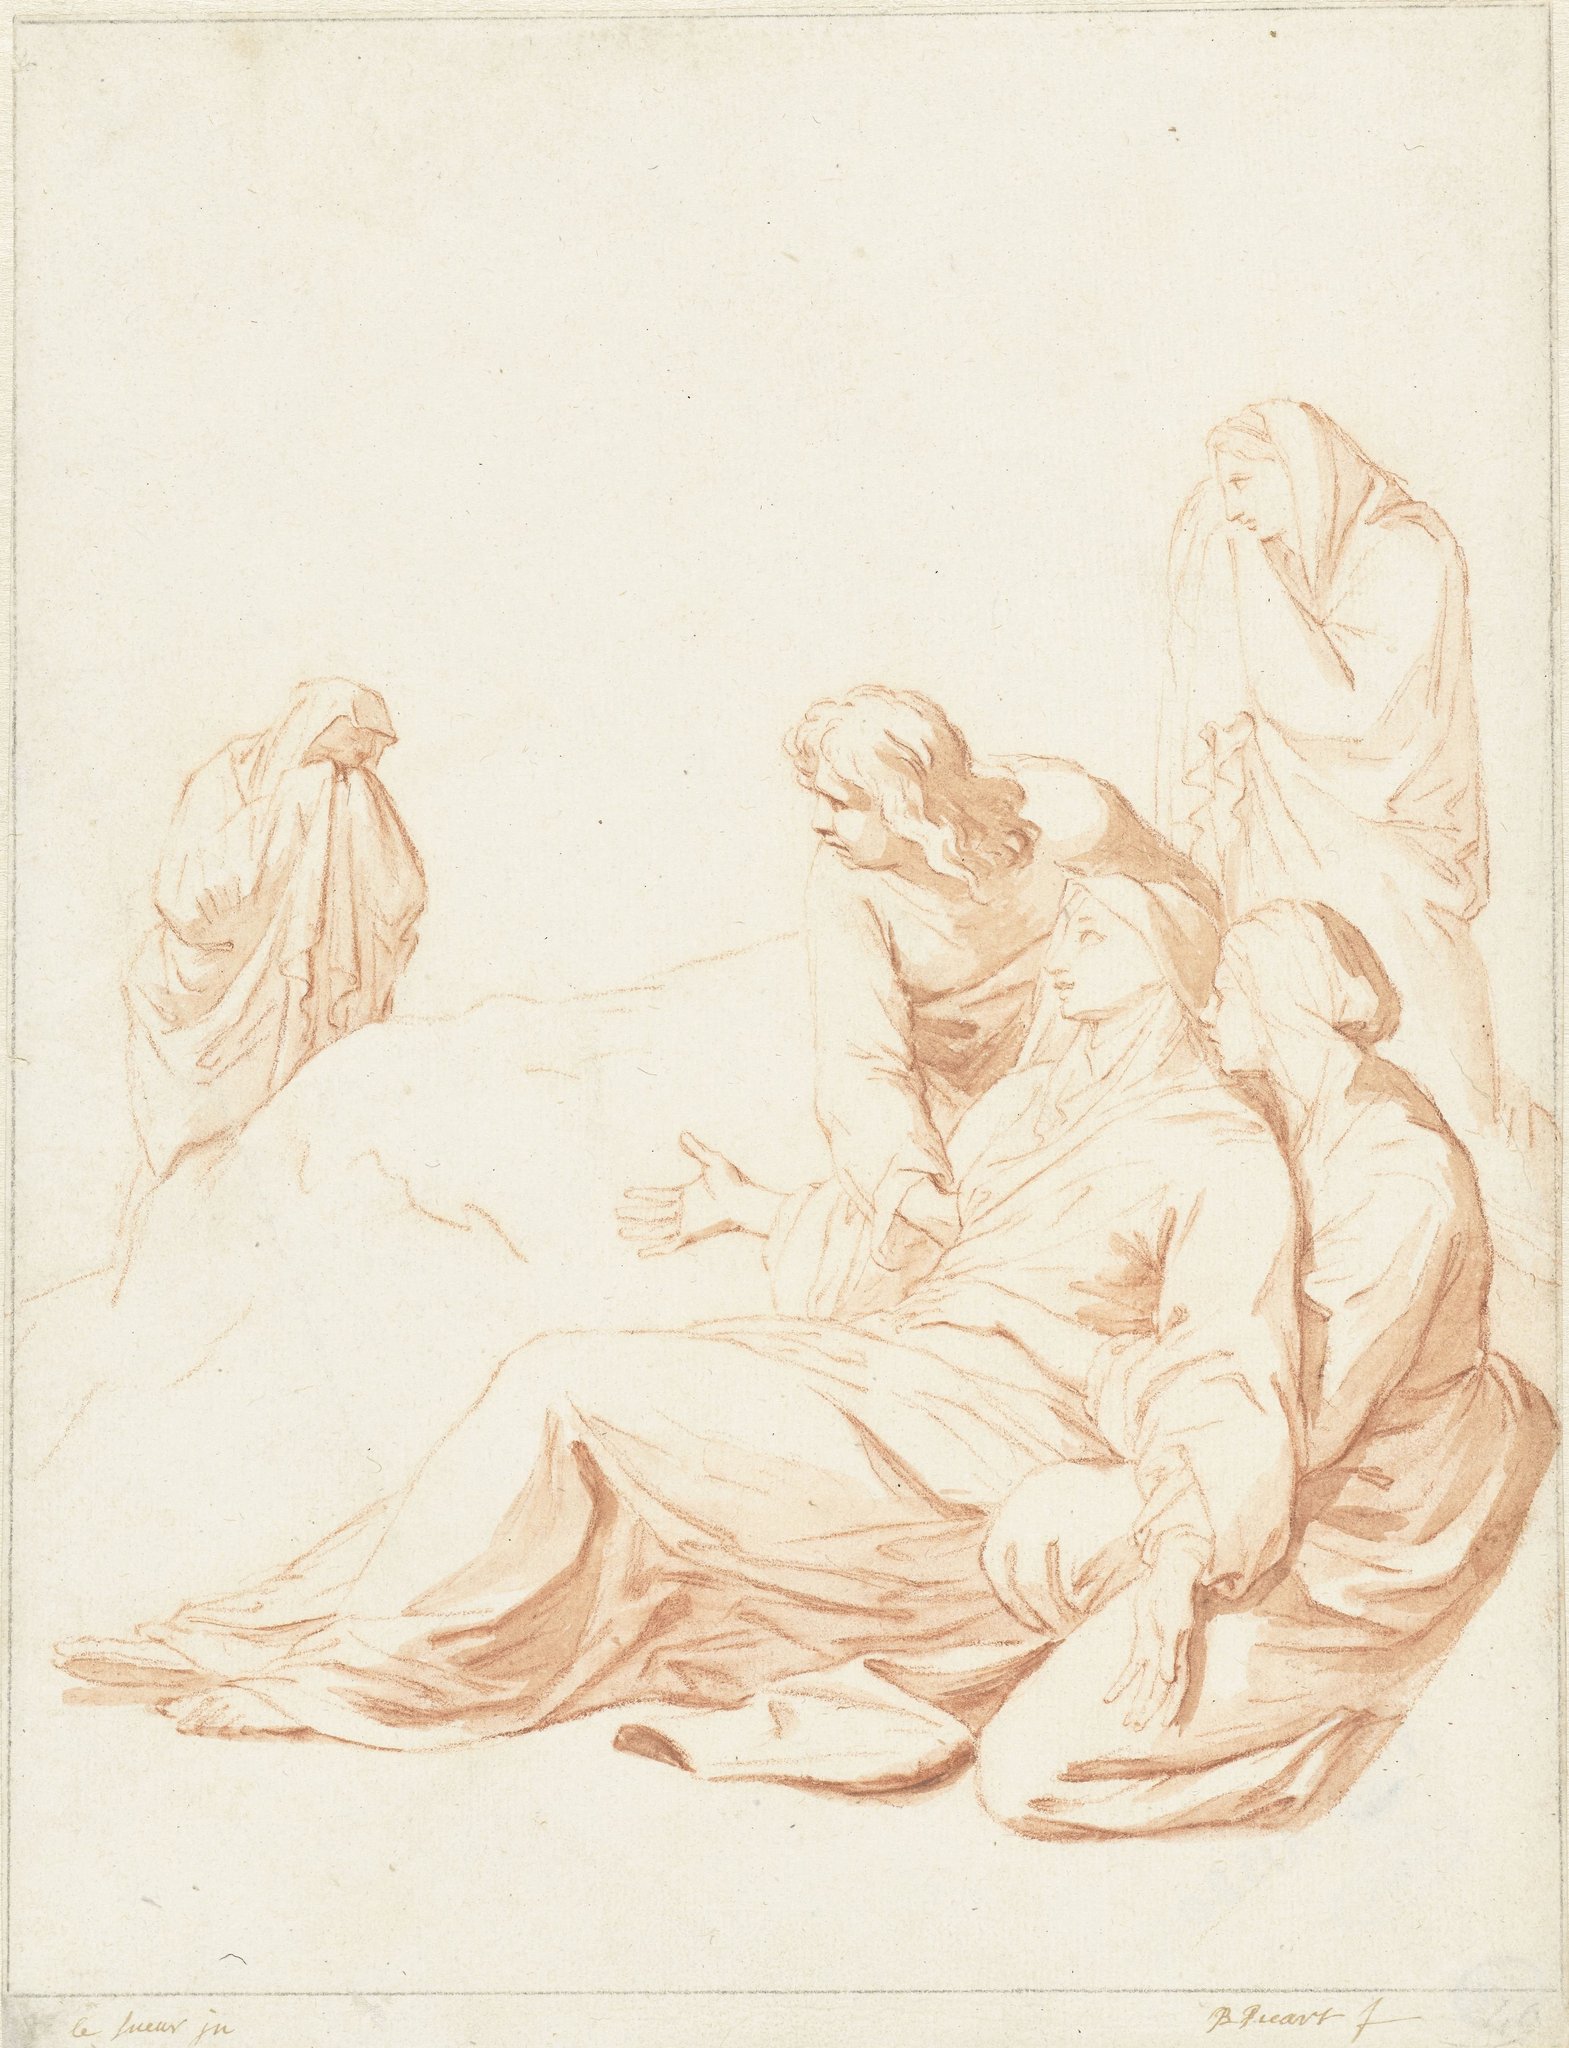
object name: drawing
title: Maria bezwijmt en wordt ondersteund door Johannes de Evangelist en een vrouw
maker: bernard picart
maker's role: draughtsman, print maker, publisher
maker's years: 1673-1733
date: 1683-1733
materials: chalk, paper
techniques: brush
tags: mary and john close together; sometimes mary swooning ~ crucified christ